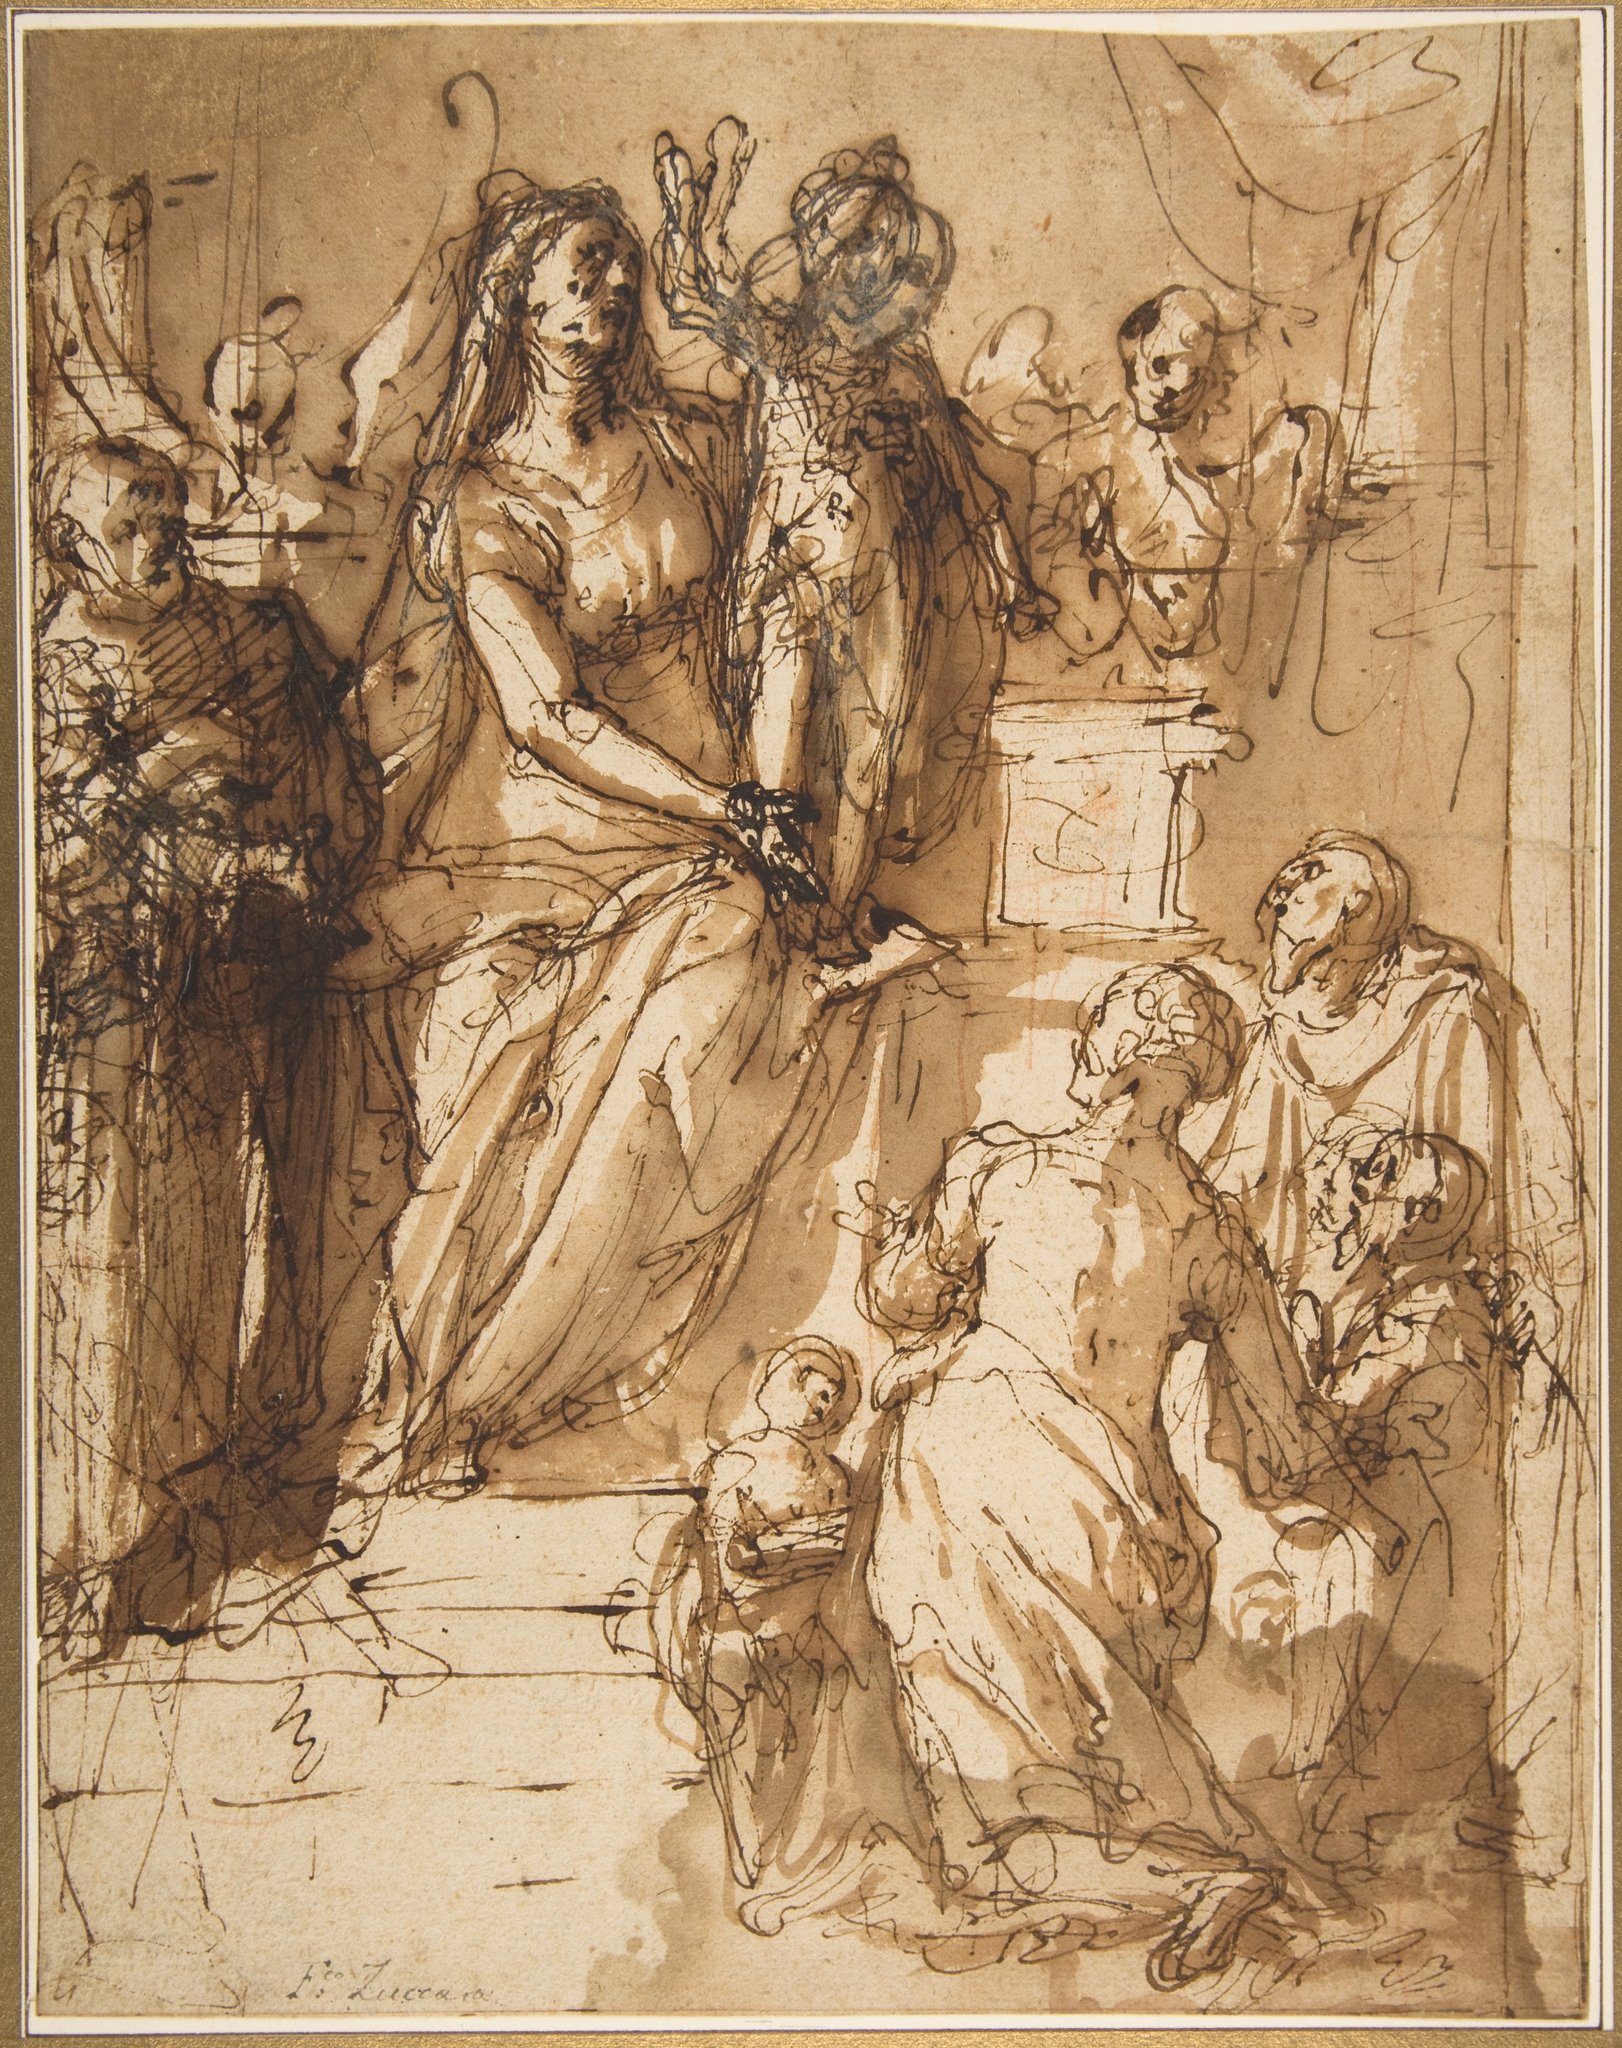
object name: drawing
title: The Virgin and Child with Saint Joseph, Attendant Angels, and a Group of Supplicants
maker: federico zuccaro (zuccari)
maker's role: artist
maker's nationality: italian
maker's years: 1540-1609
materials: chalk, ink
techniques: brush, pen, wash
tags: angels,madonna and child,saint joseph